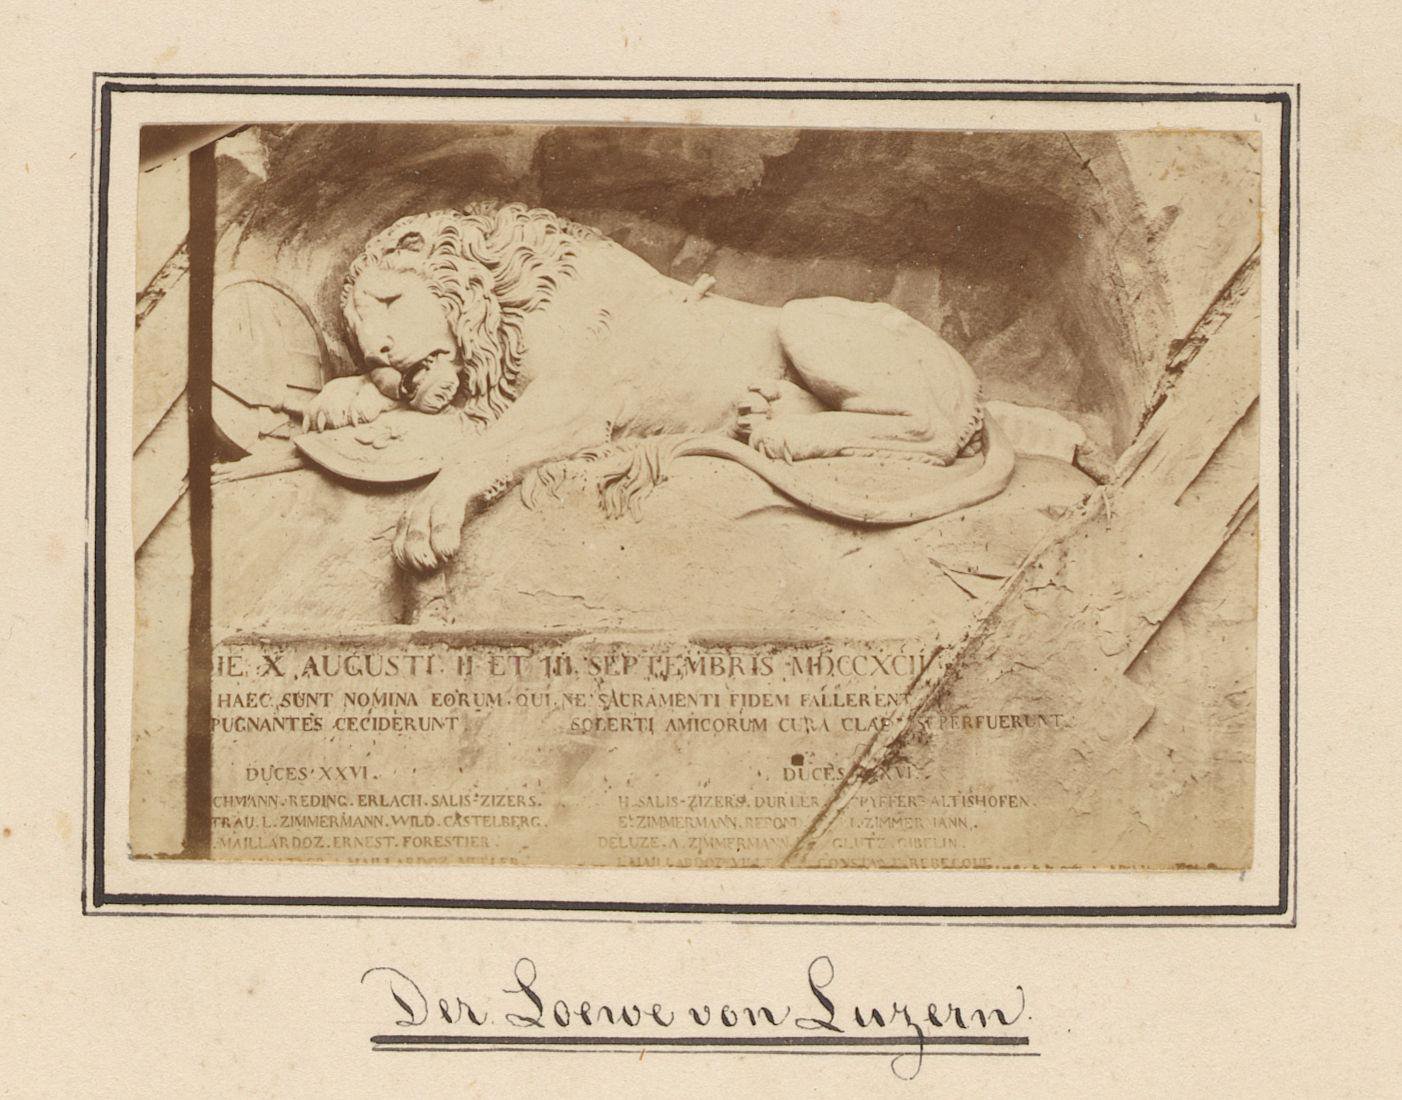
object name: album leaf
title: Leeuwenmonument van Luzern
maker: Anonymous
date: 1870-1890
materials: paper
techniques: albumen print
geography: altdorf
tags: monument, statue